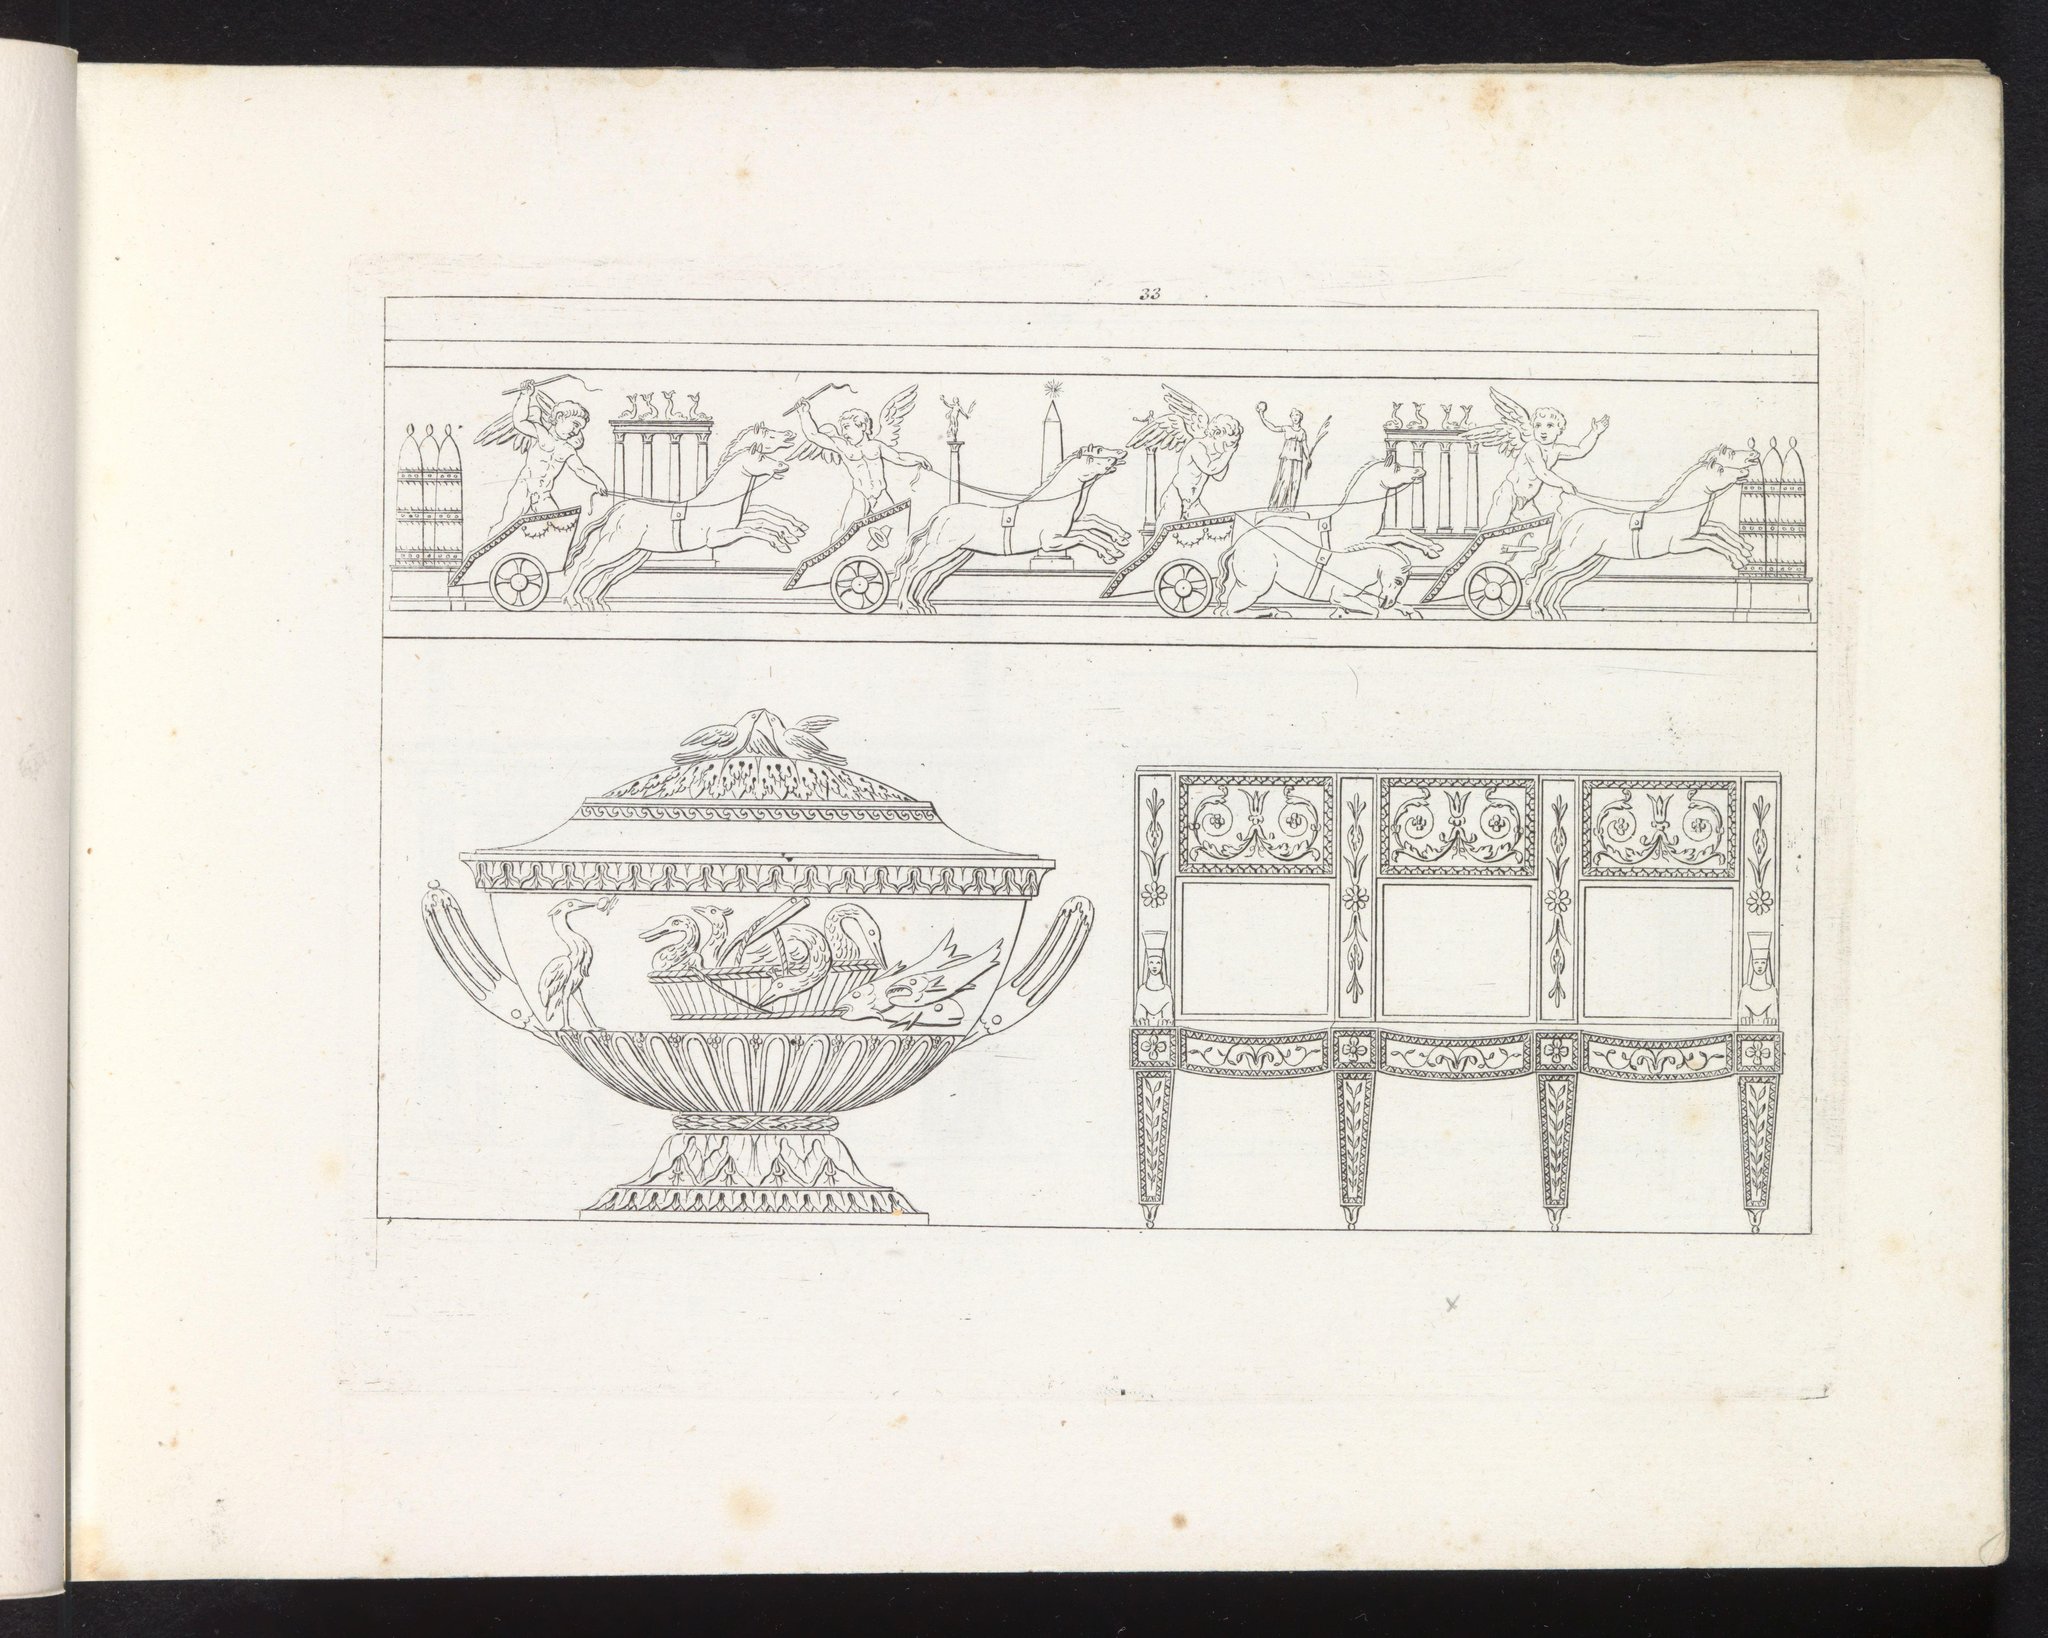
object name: album leaf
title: Invenzioni diverse di mobili ed utensili sacri e profani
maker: pietro ruga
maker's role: print maker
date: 1817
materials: paper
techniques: etching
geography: italy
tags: bench, ornaments ~ art, piece of sculpture, reproduction of a piece of sculpture, bowl, cupids: 'amores', 'amoretti', 'putti'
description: Prent maakt deel uit van een reeks van 100 prenten (+ titelprent) met ontwerpen voor religieuze en profane voorwerpen.